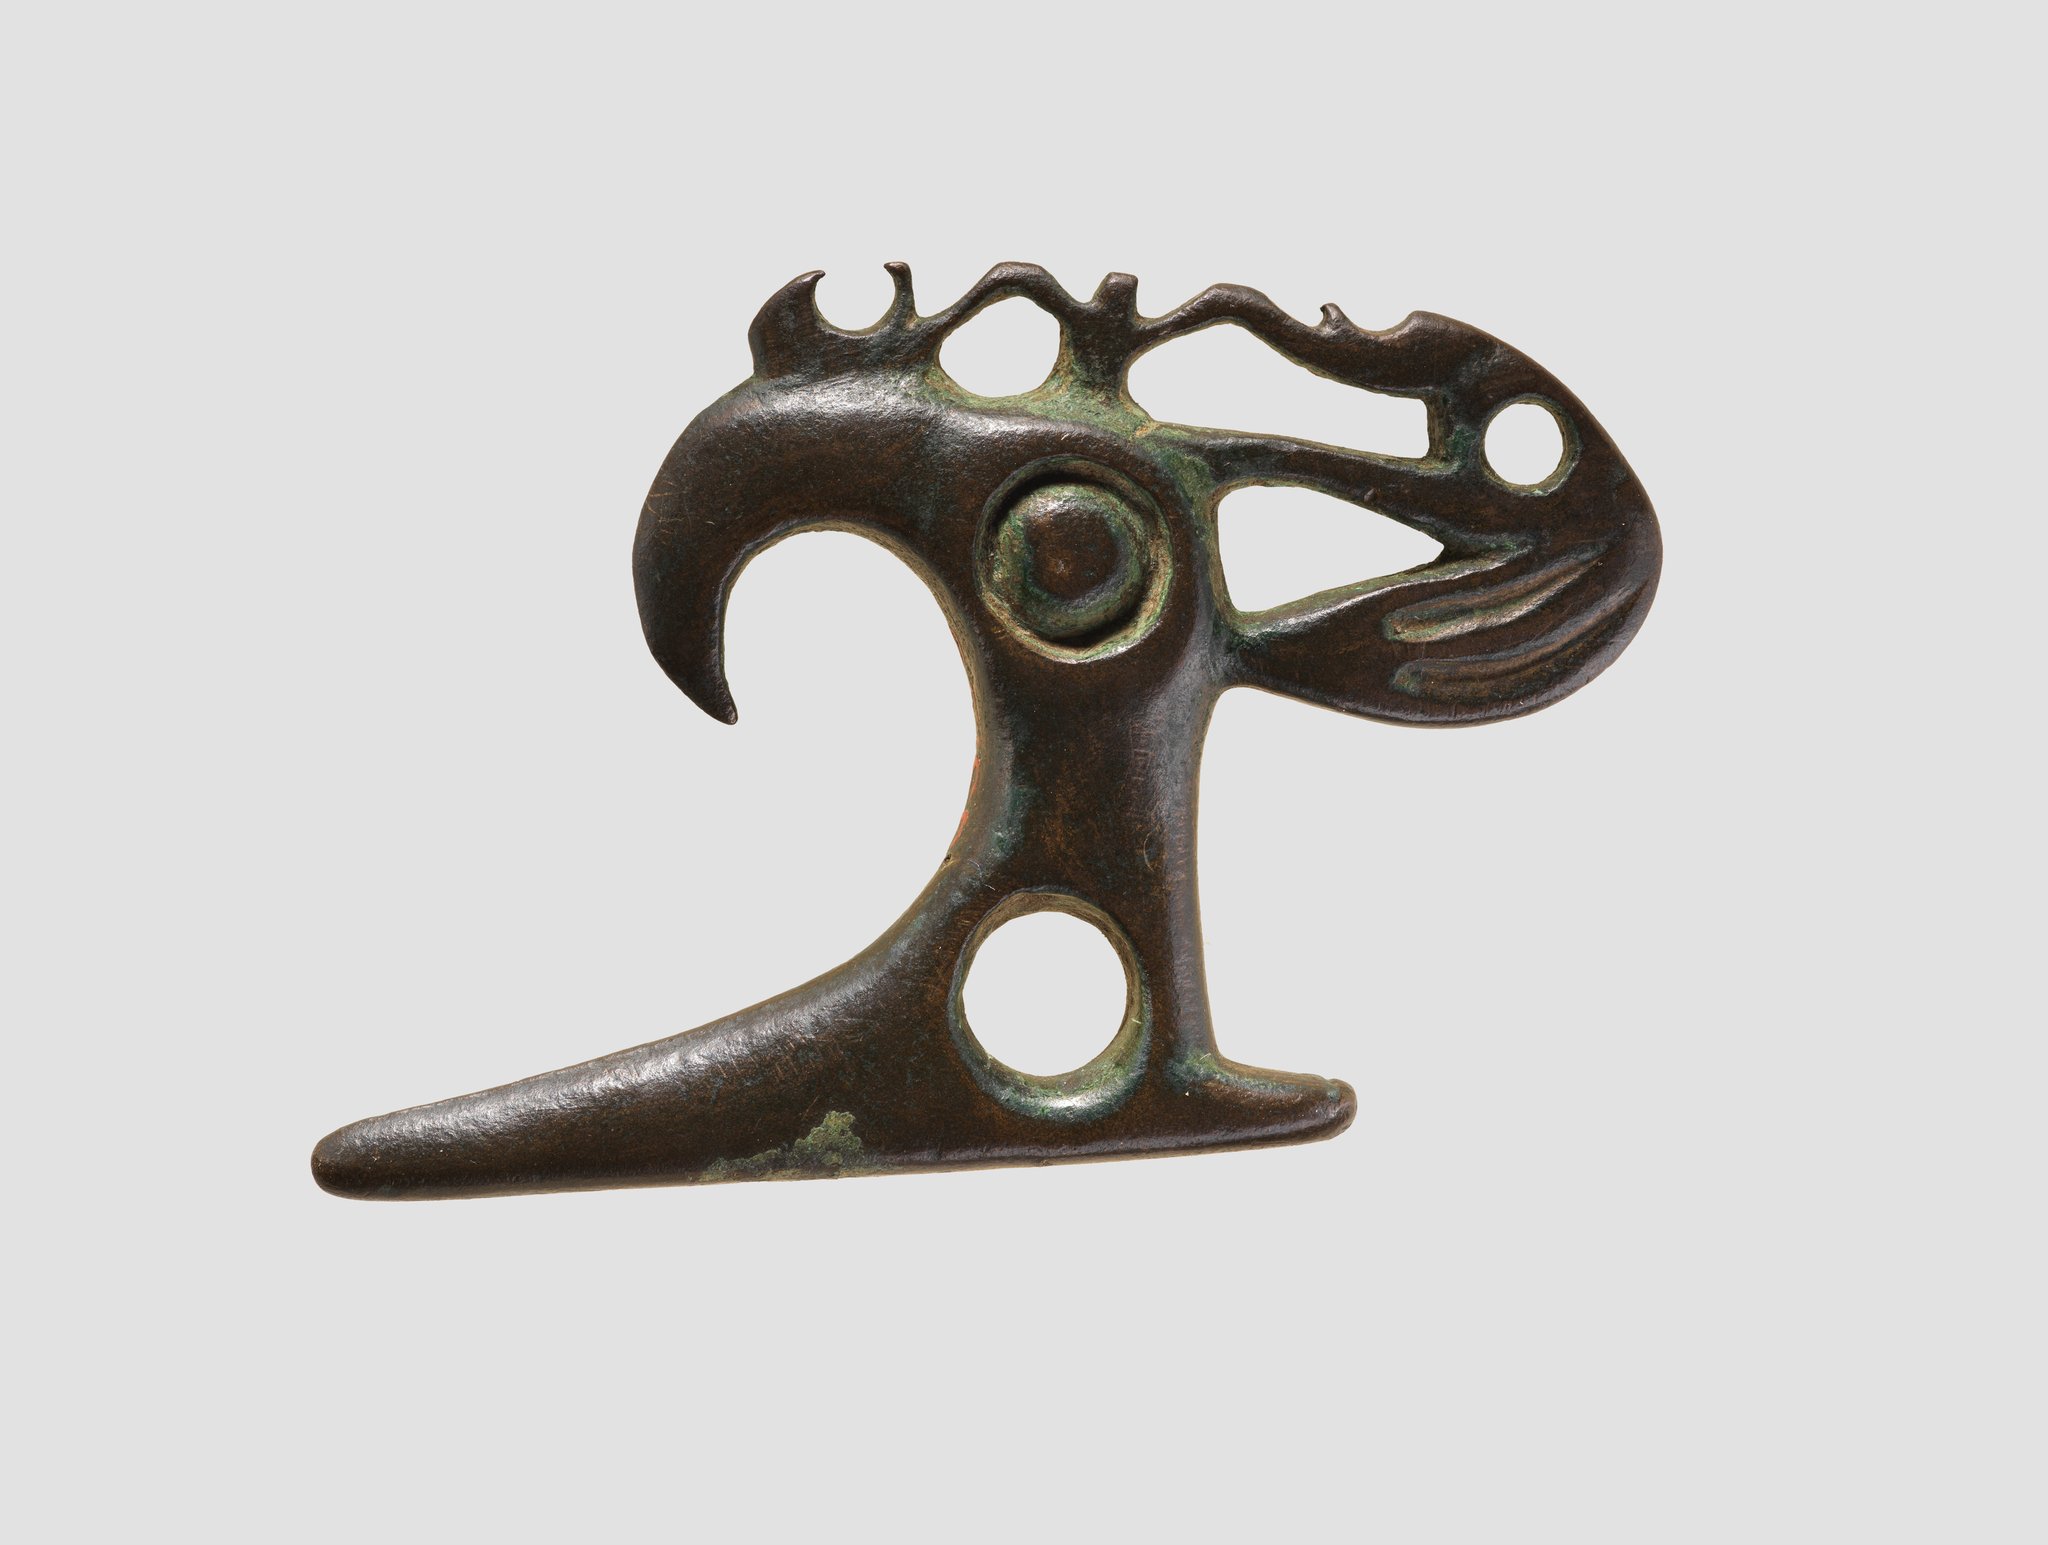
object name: tassel holder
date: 500-301 BCE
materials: bronze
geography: eurasian steppes